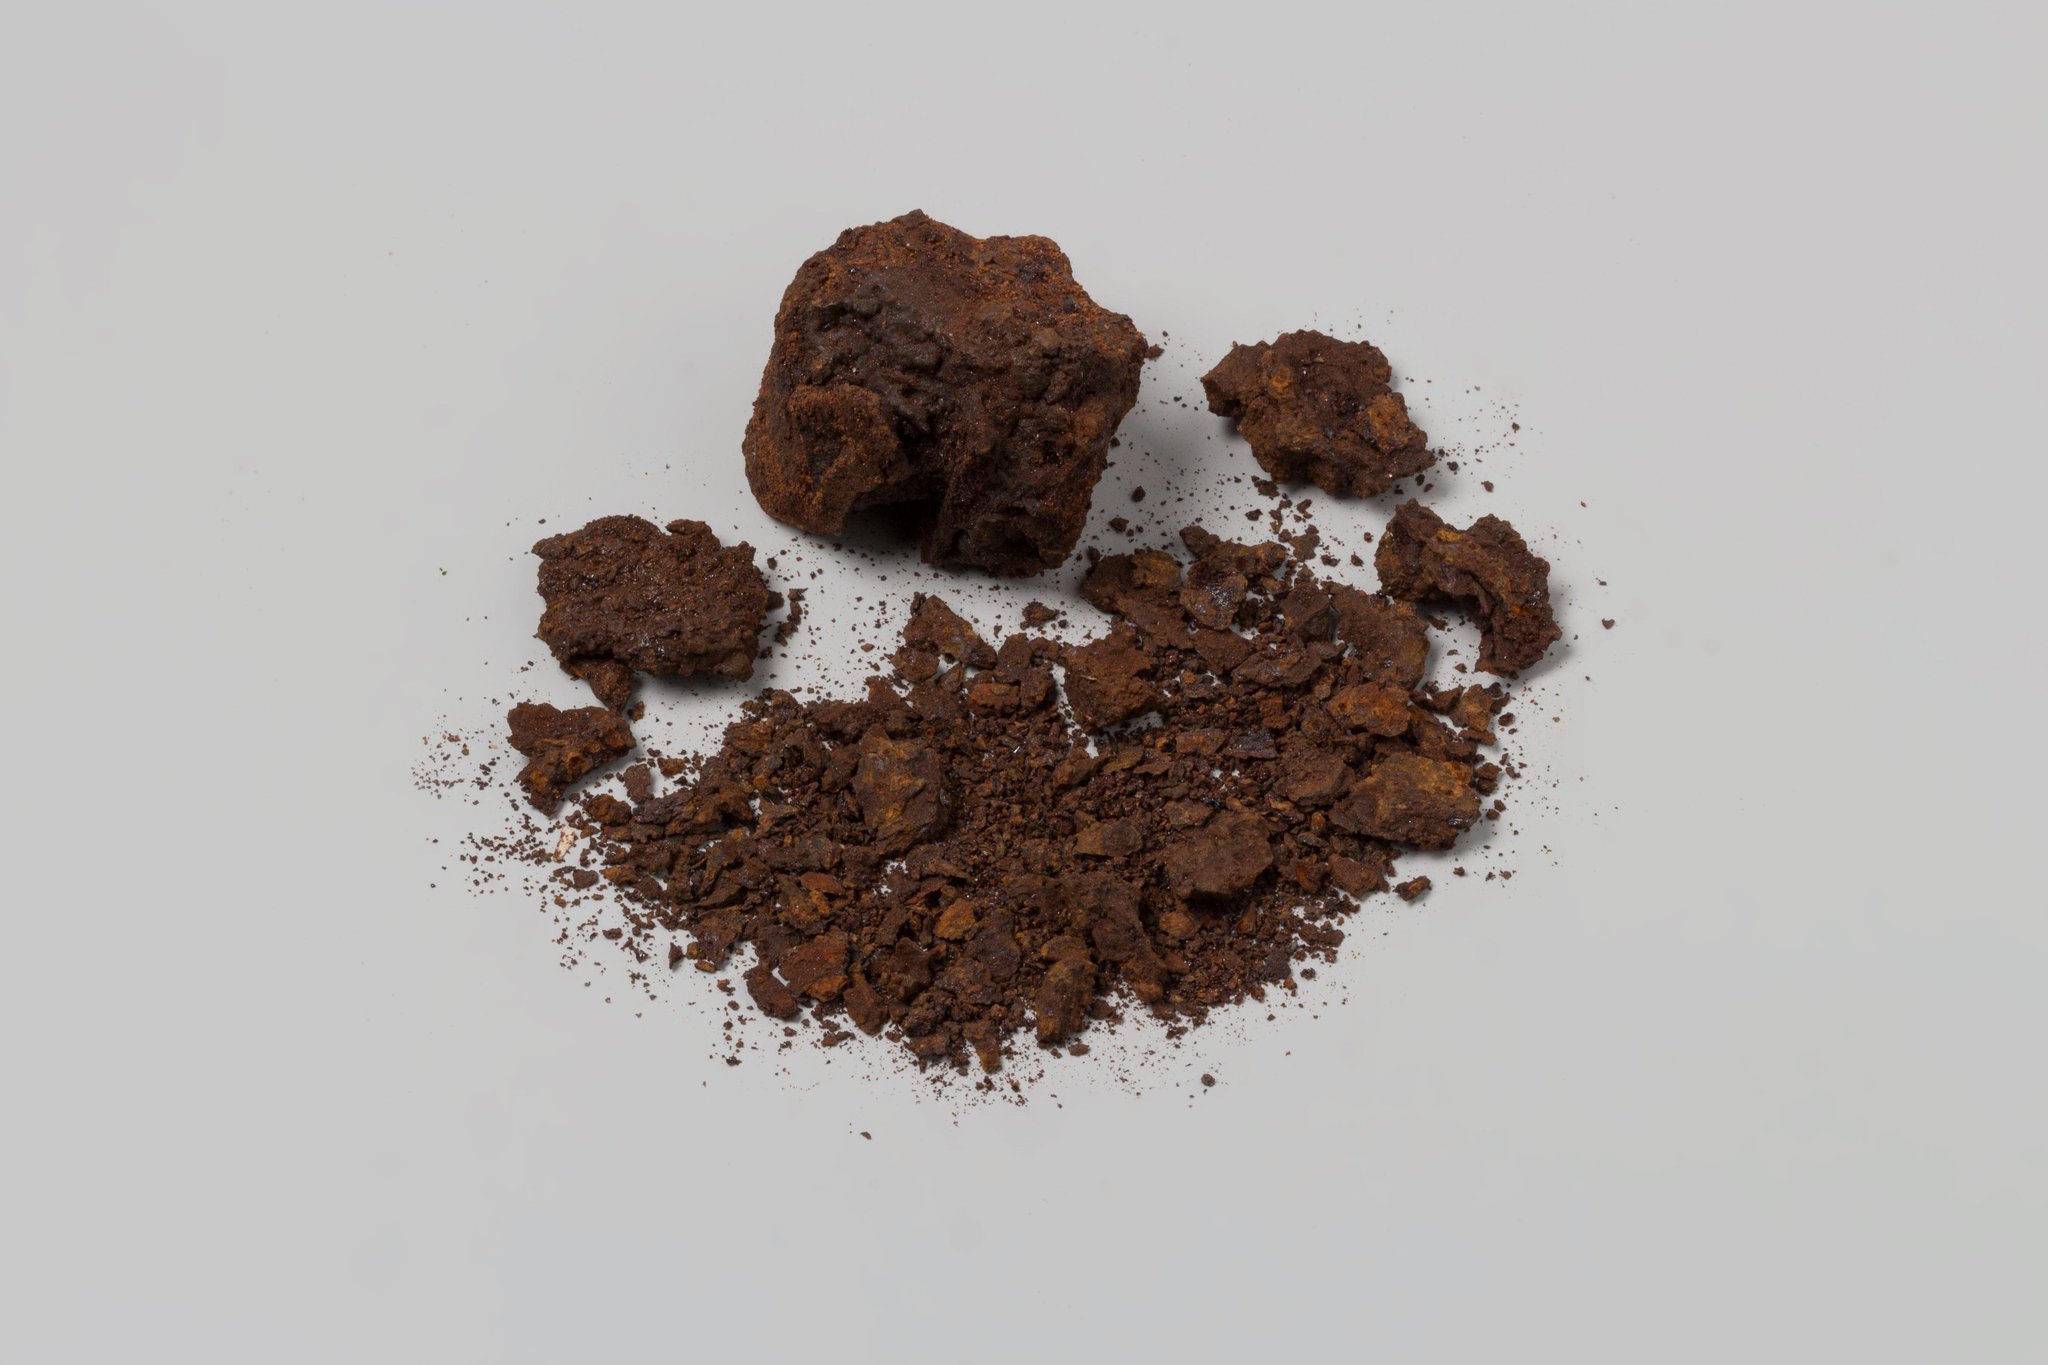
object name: fragment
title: Fragmenten ijzer en gruis uit het wrak van de Oost-Indiëvaarder Hollandia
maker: Anonymous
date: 1700-1743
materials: iron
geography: netherlands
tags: verenigde oostindische compagnie, hollandia (schip), annet